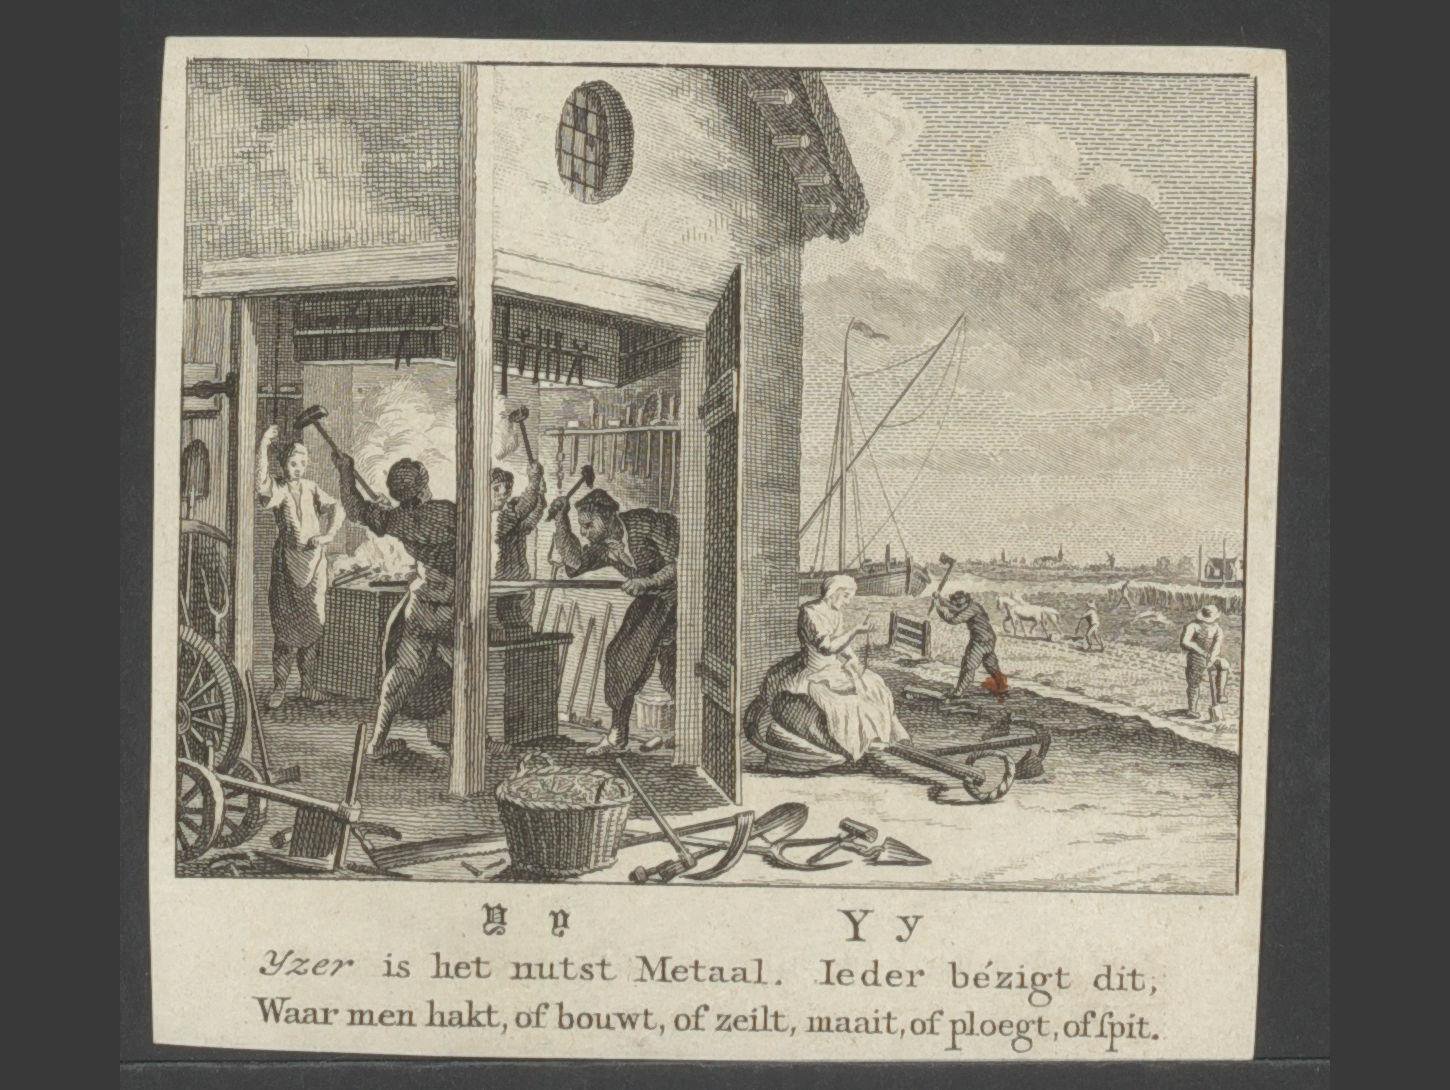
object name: book illustration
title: Smederij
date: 1781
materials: paper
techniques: engraving, etching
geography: amsterdam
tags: letters, alphabet, script, smith, blacksmith, iron and steel industry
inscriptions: collector's mark: Lugt 1641, stamp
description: Onder de voorstelling de letter Y in twee verschillende lettertypes. Onderaan een tweeregelig vers over ijzer. Onderwerpsrubrieken binnen de Atlas Zeden en Gewoonten: Onderwijs en Wetenschappen, Opvoeding en Onderwijs, Haneboeken en schoolprenten.